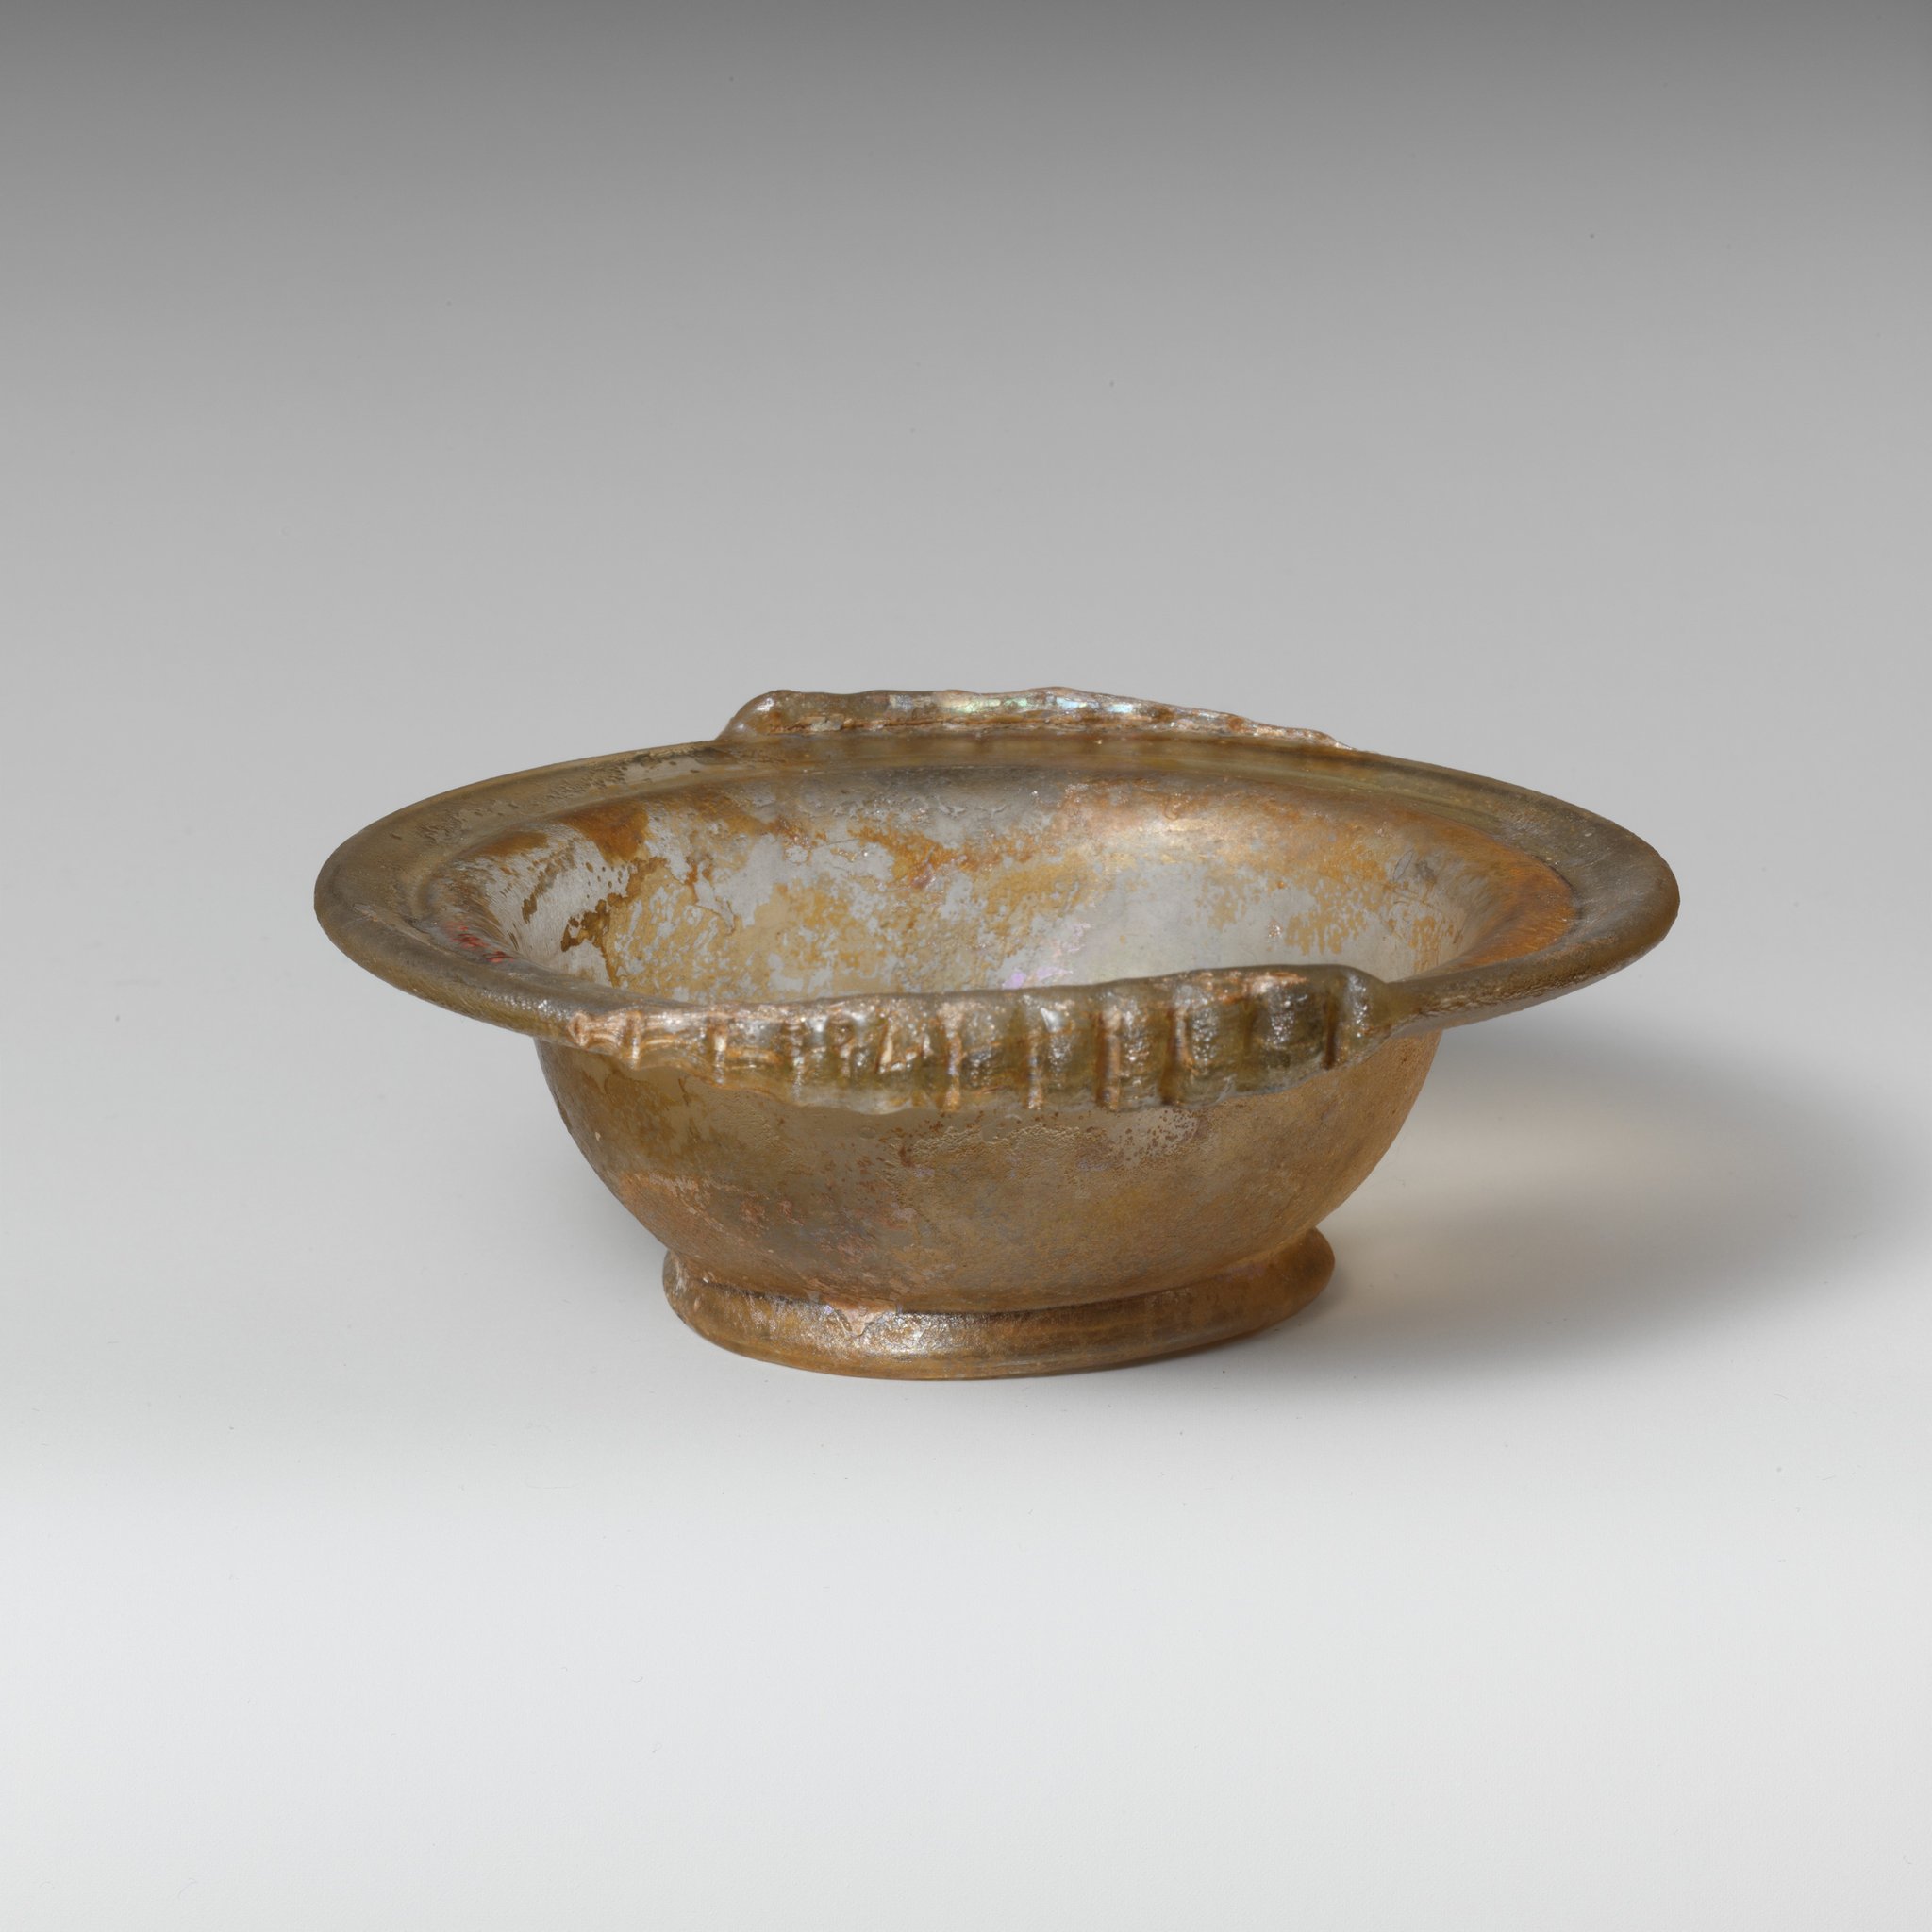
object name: bowl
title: Glass bowl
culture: roman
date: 67-233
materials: glass